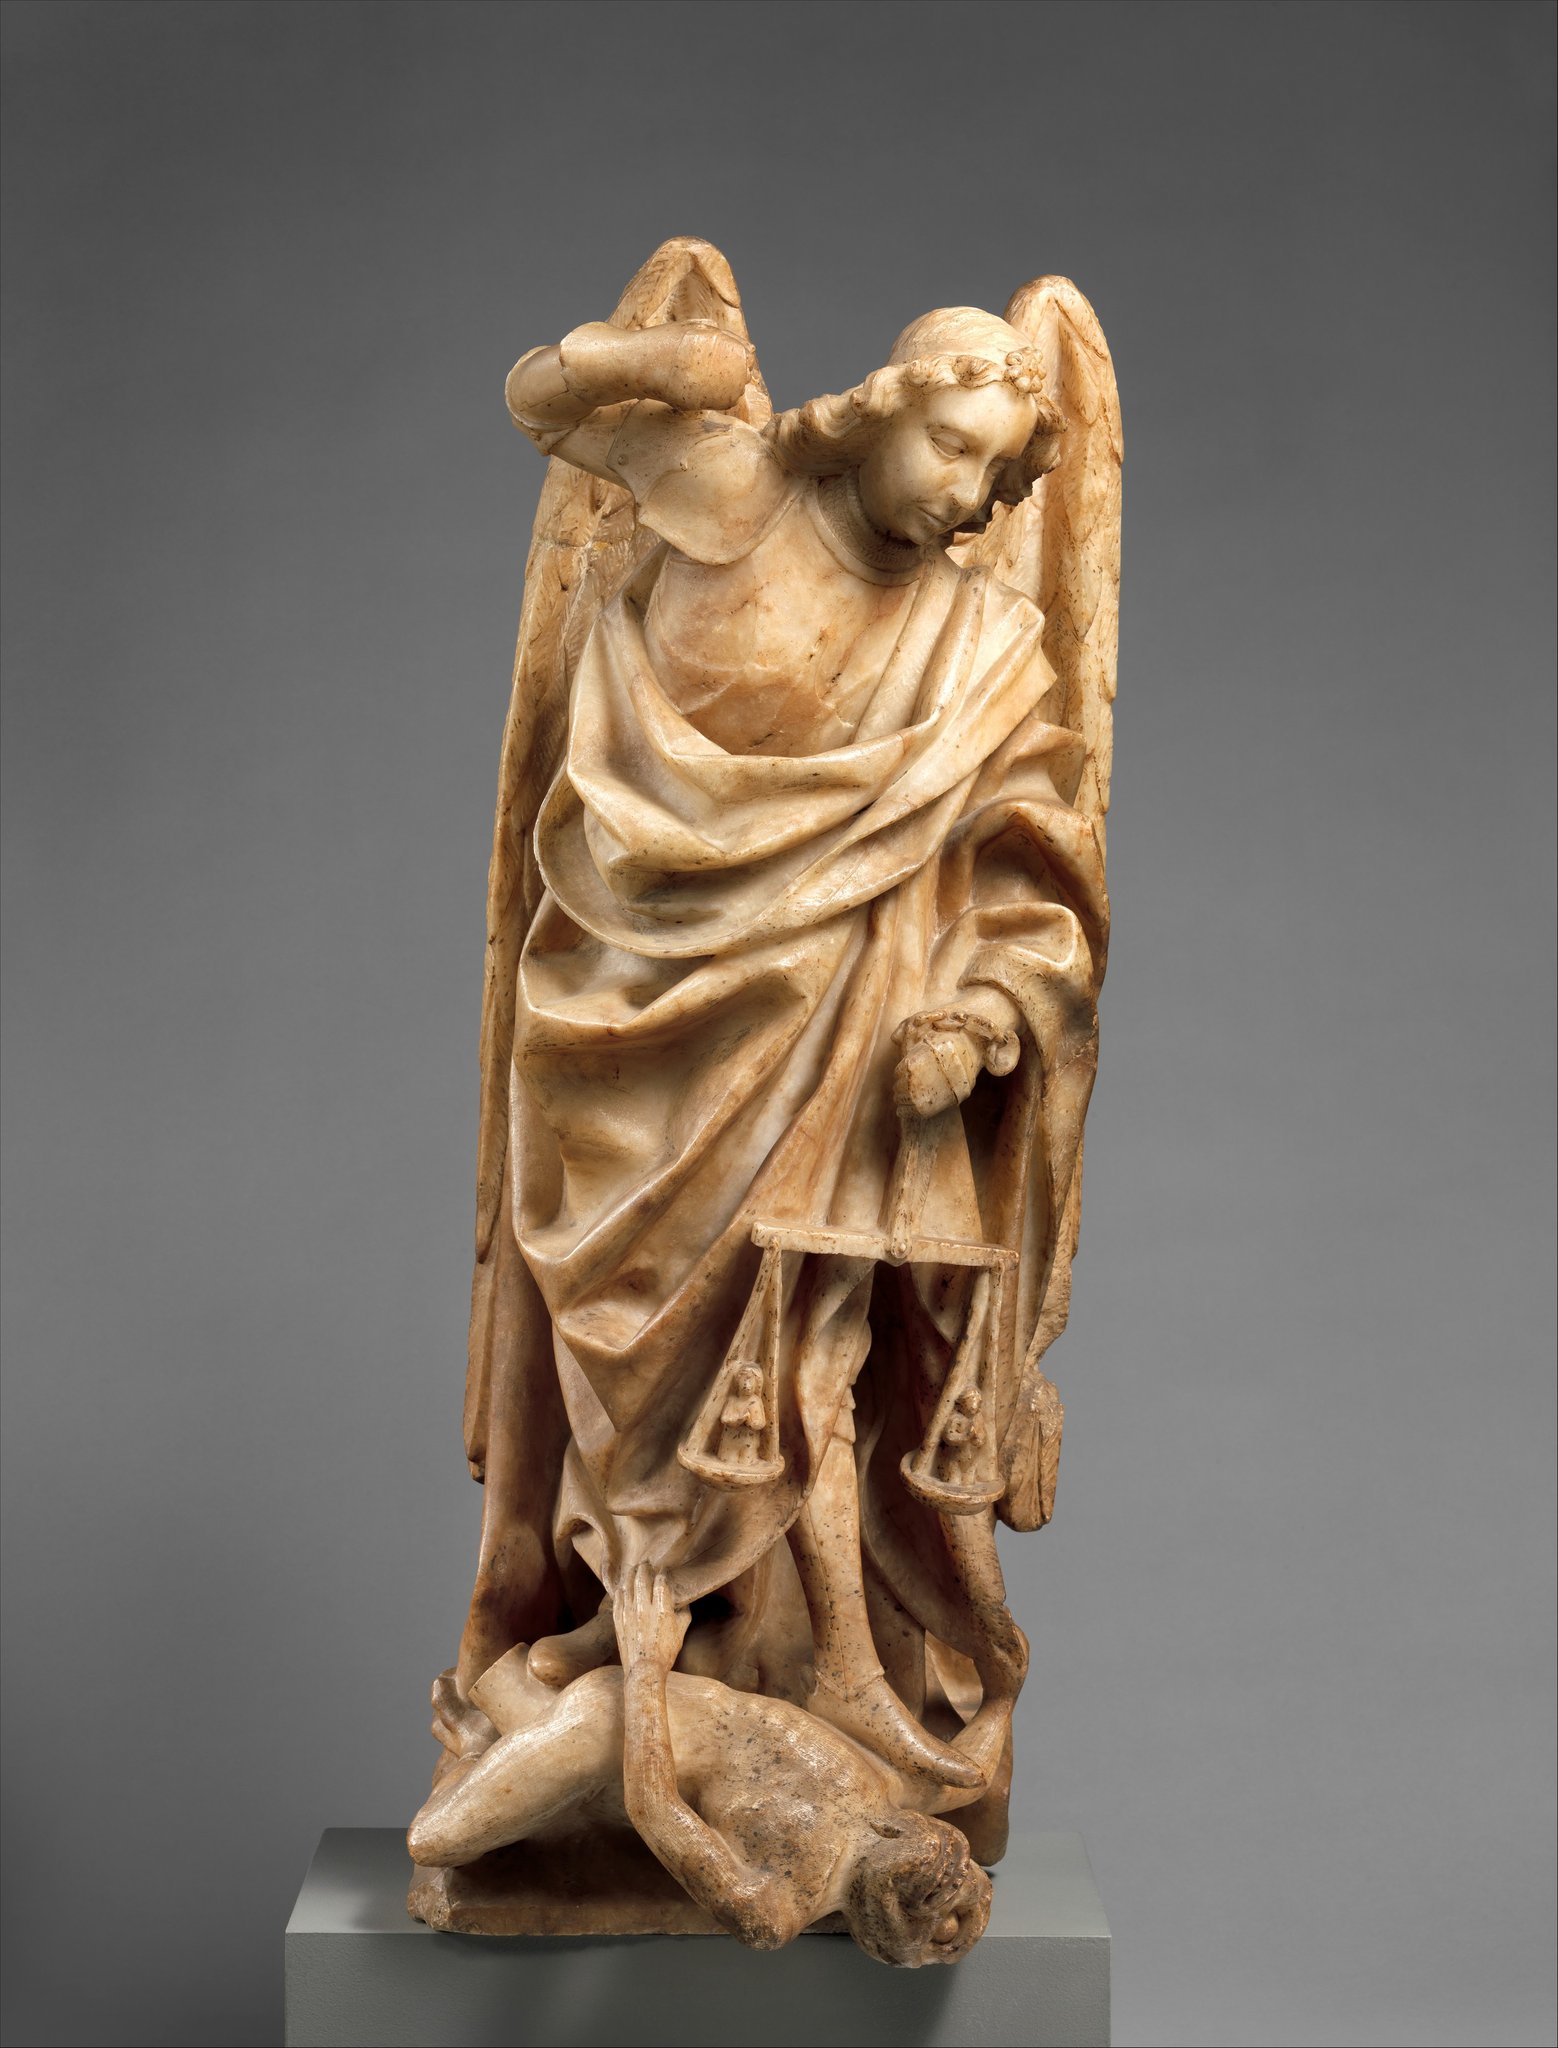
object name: statuette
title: St. Michael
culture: spanish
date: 1467-1500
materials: alabaster